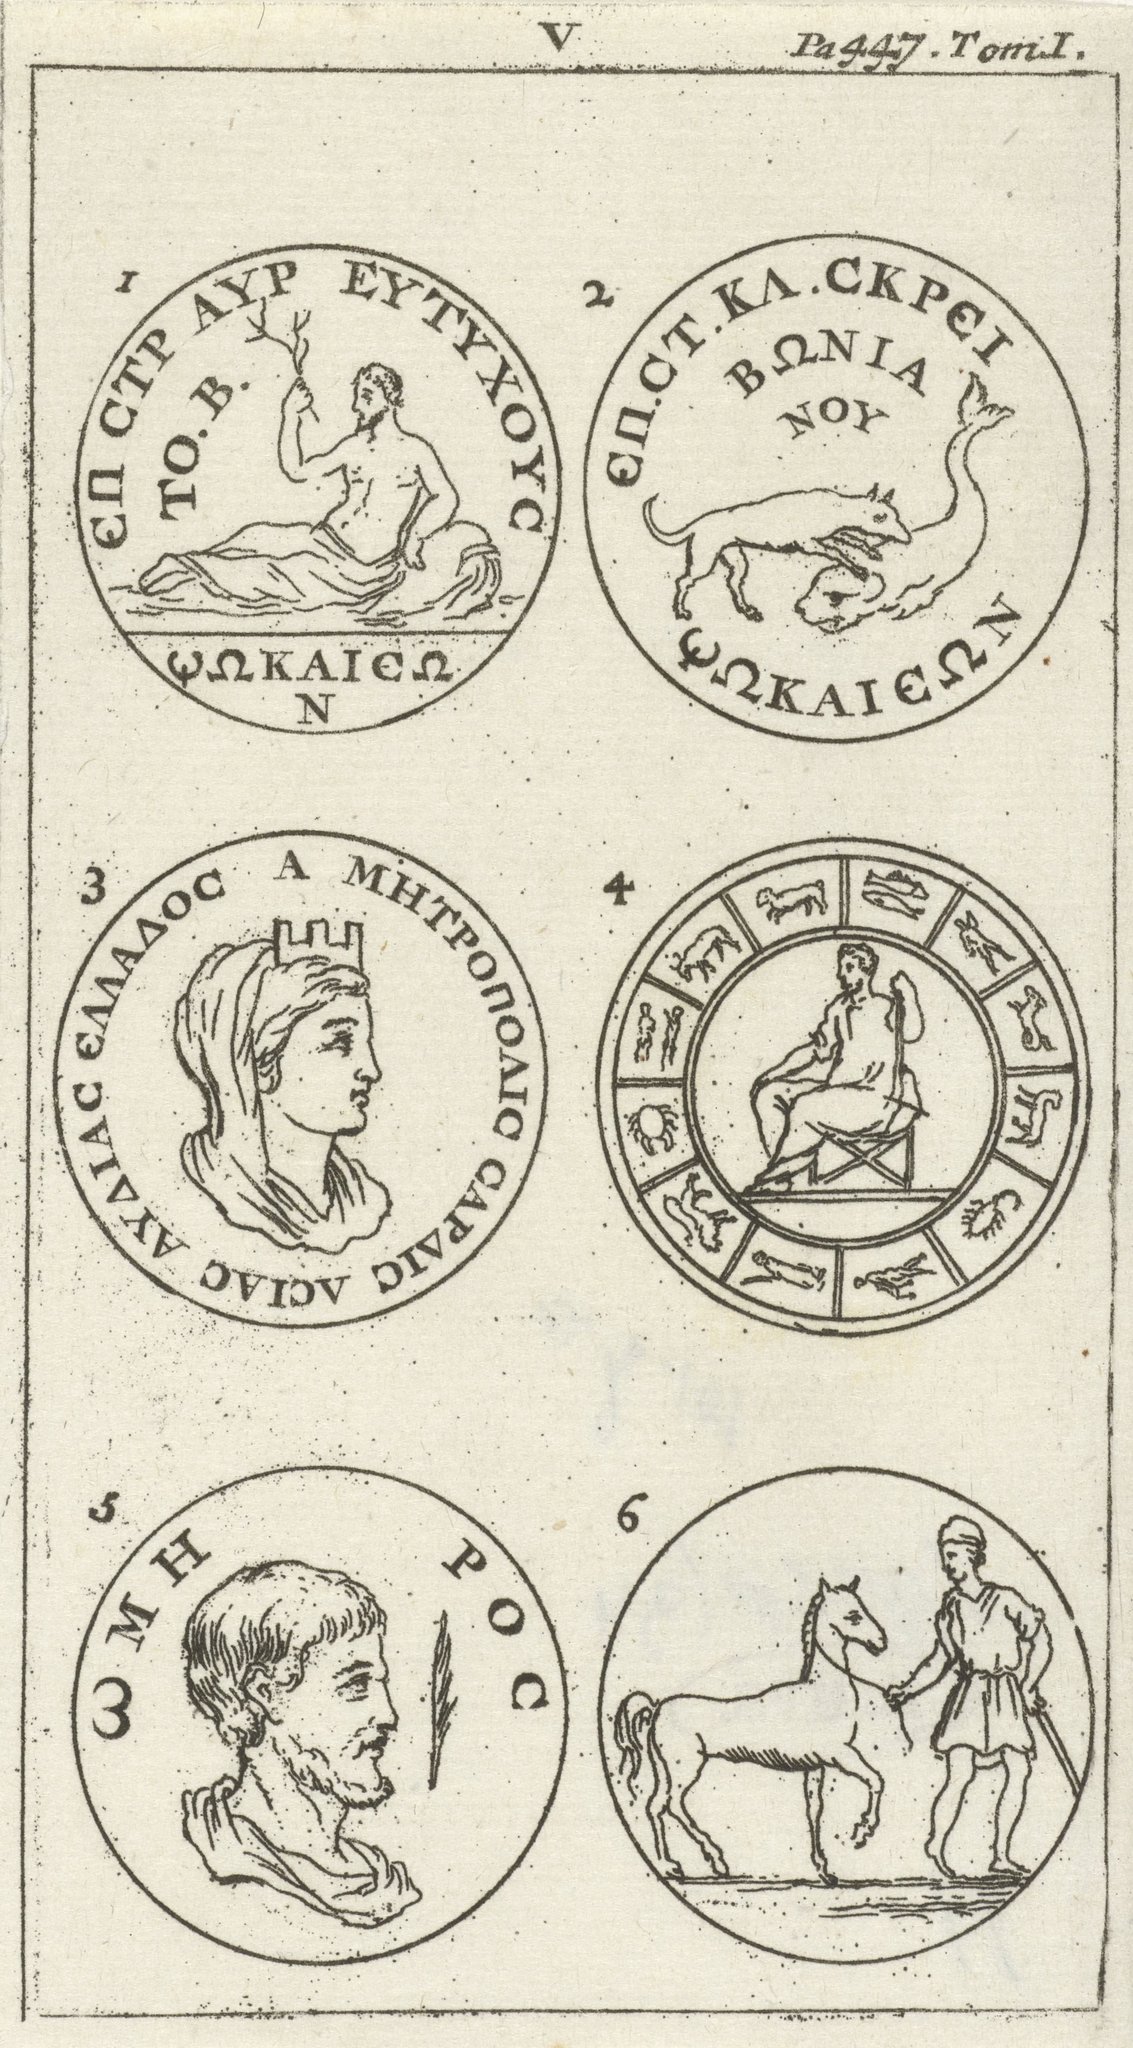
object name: book illustration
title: Acht penningen, V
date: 1679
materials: paper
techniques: etching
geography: amsterdam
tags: memorial medal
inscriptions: collector's mark: Lugt 2228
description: Illustratie opgenomen in: Spon, Jacob. Voyage d'Italie, de Dalmatie, de Grece, et du Levant, 2 delen. Amsterdam: Hendrick en Dirk Boom, 1679, dl. II, p. 447.